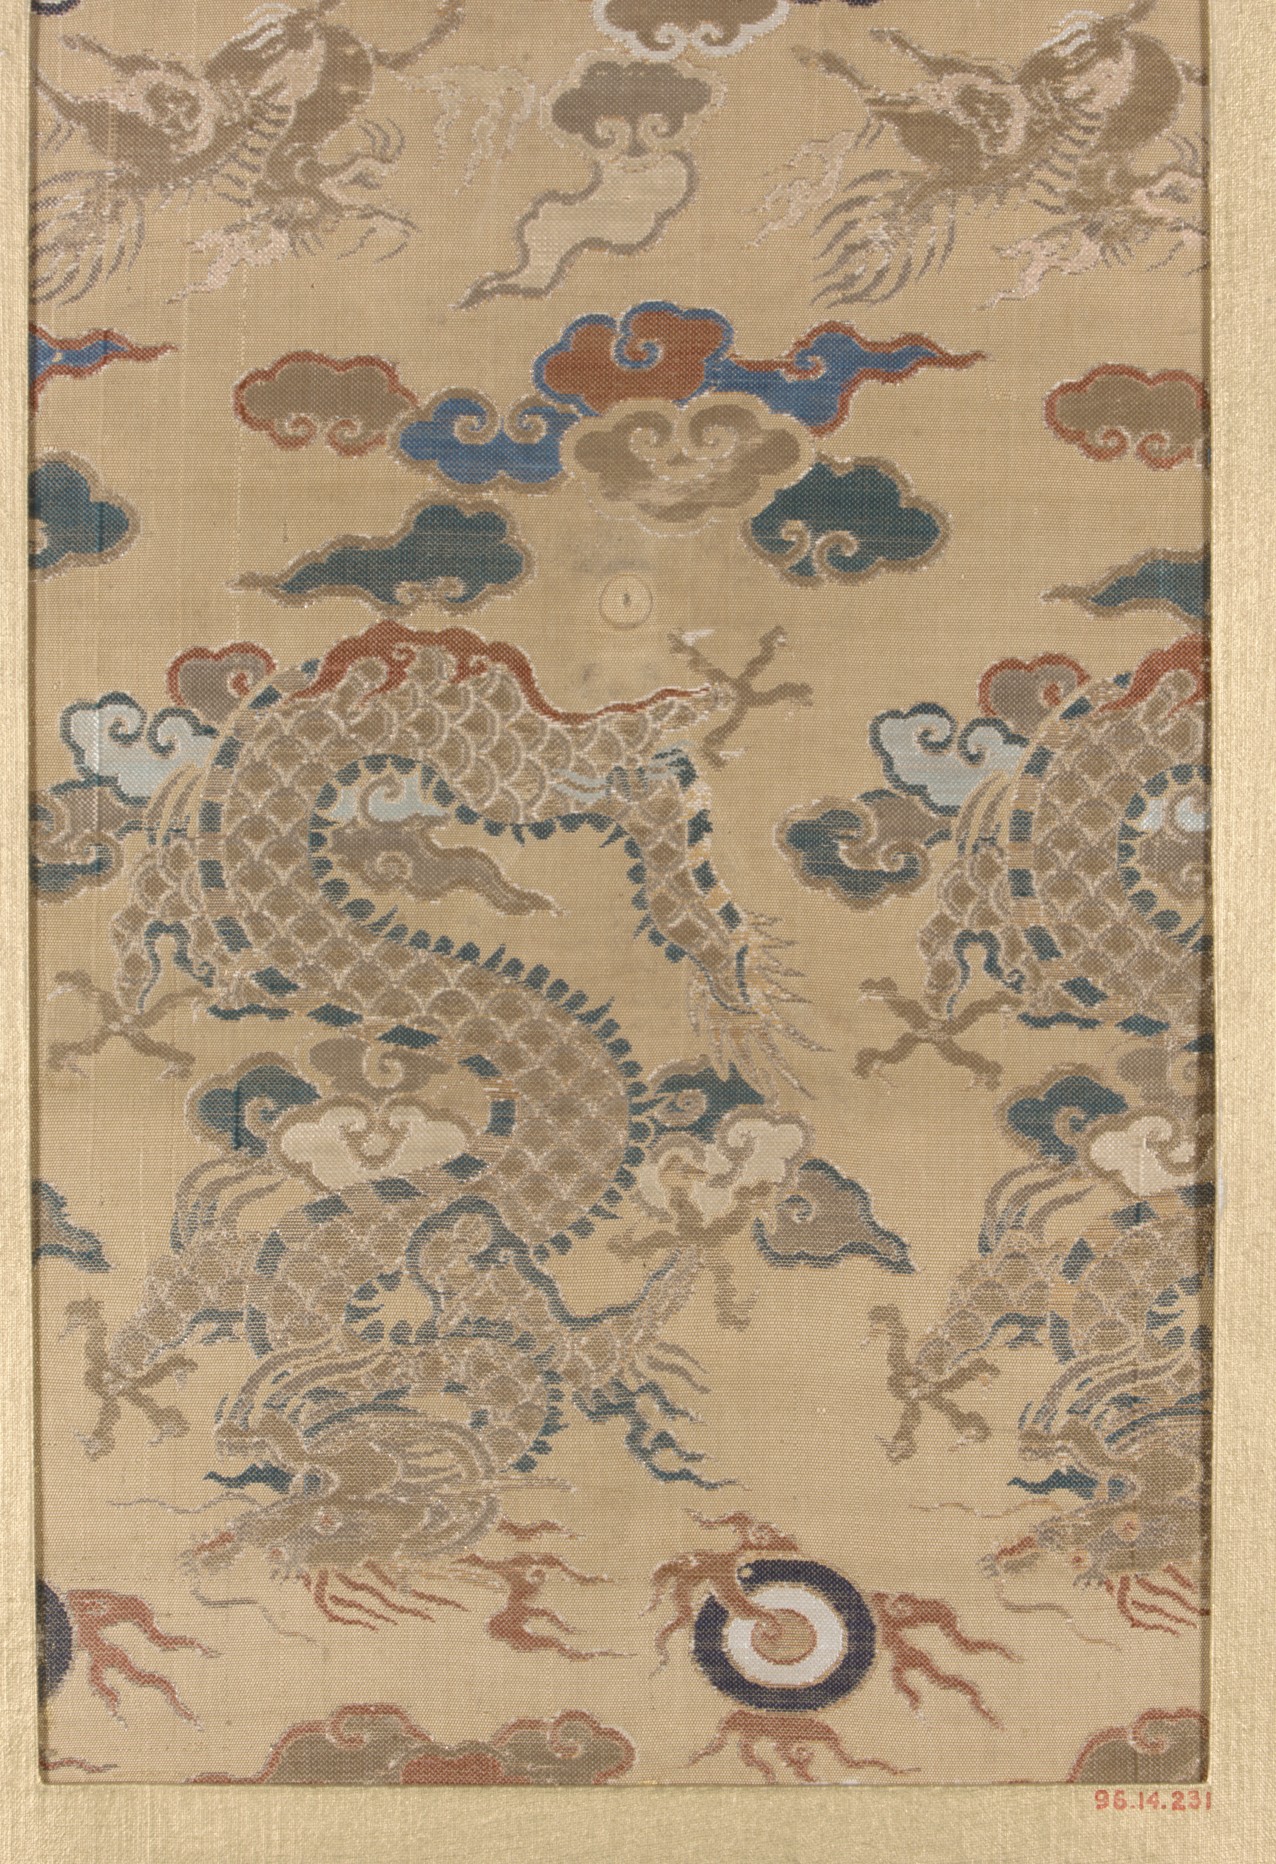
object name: piece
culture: chinese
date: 1701-1900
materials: silk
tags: dragons